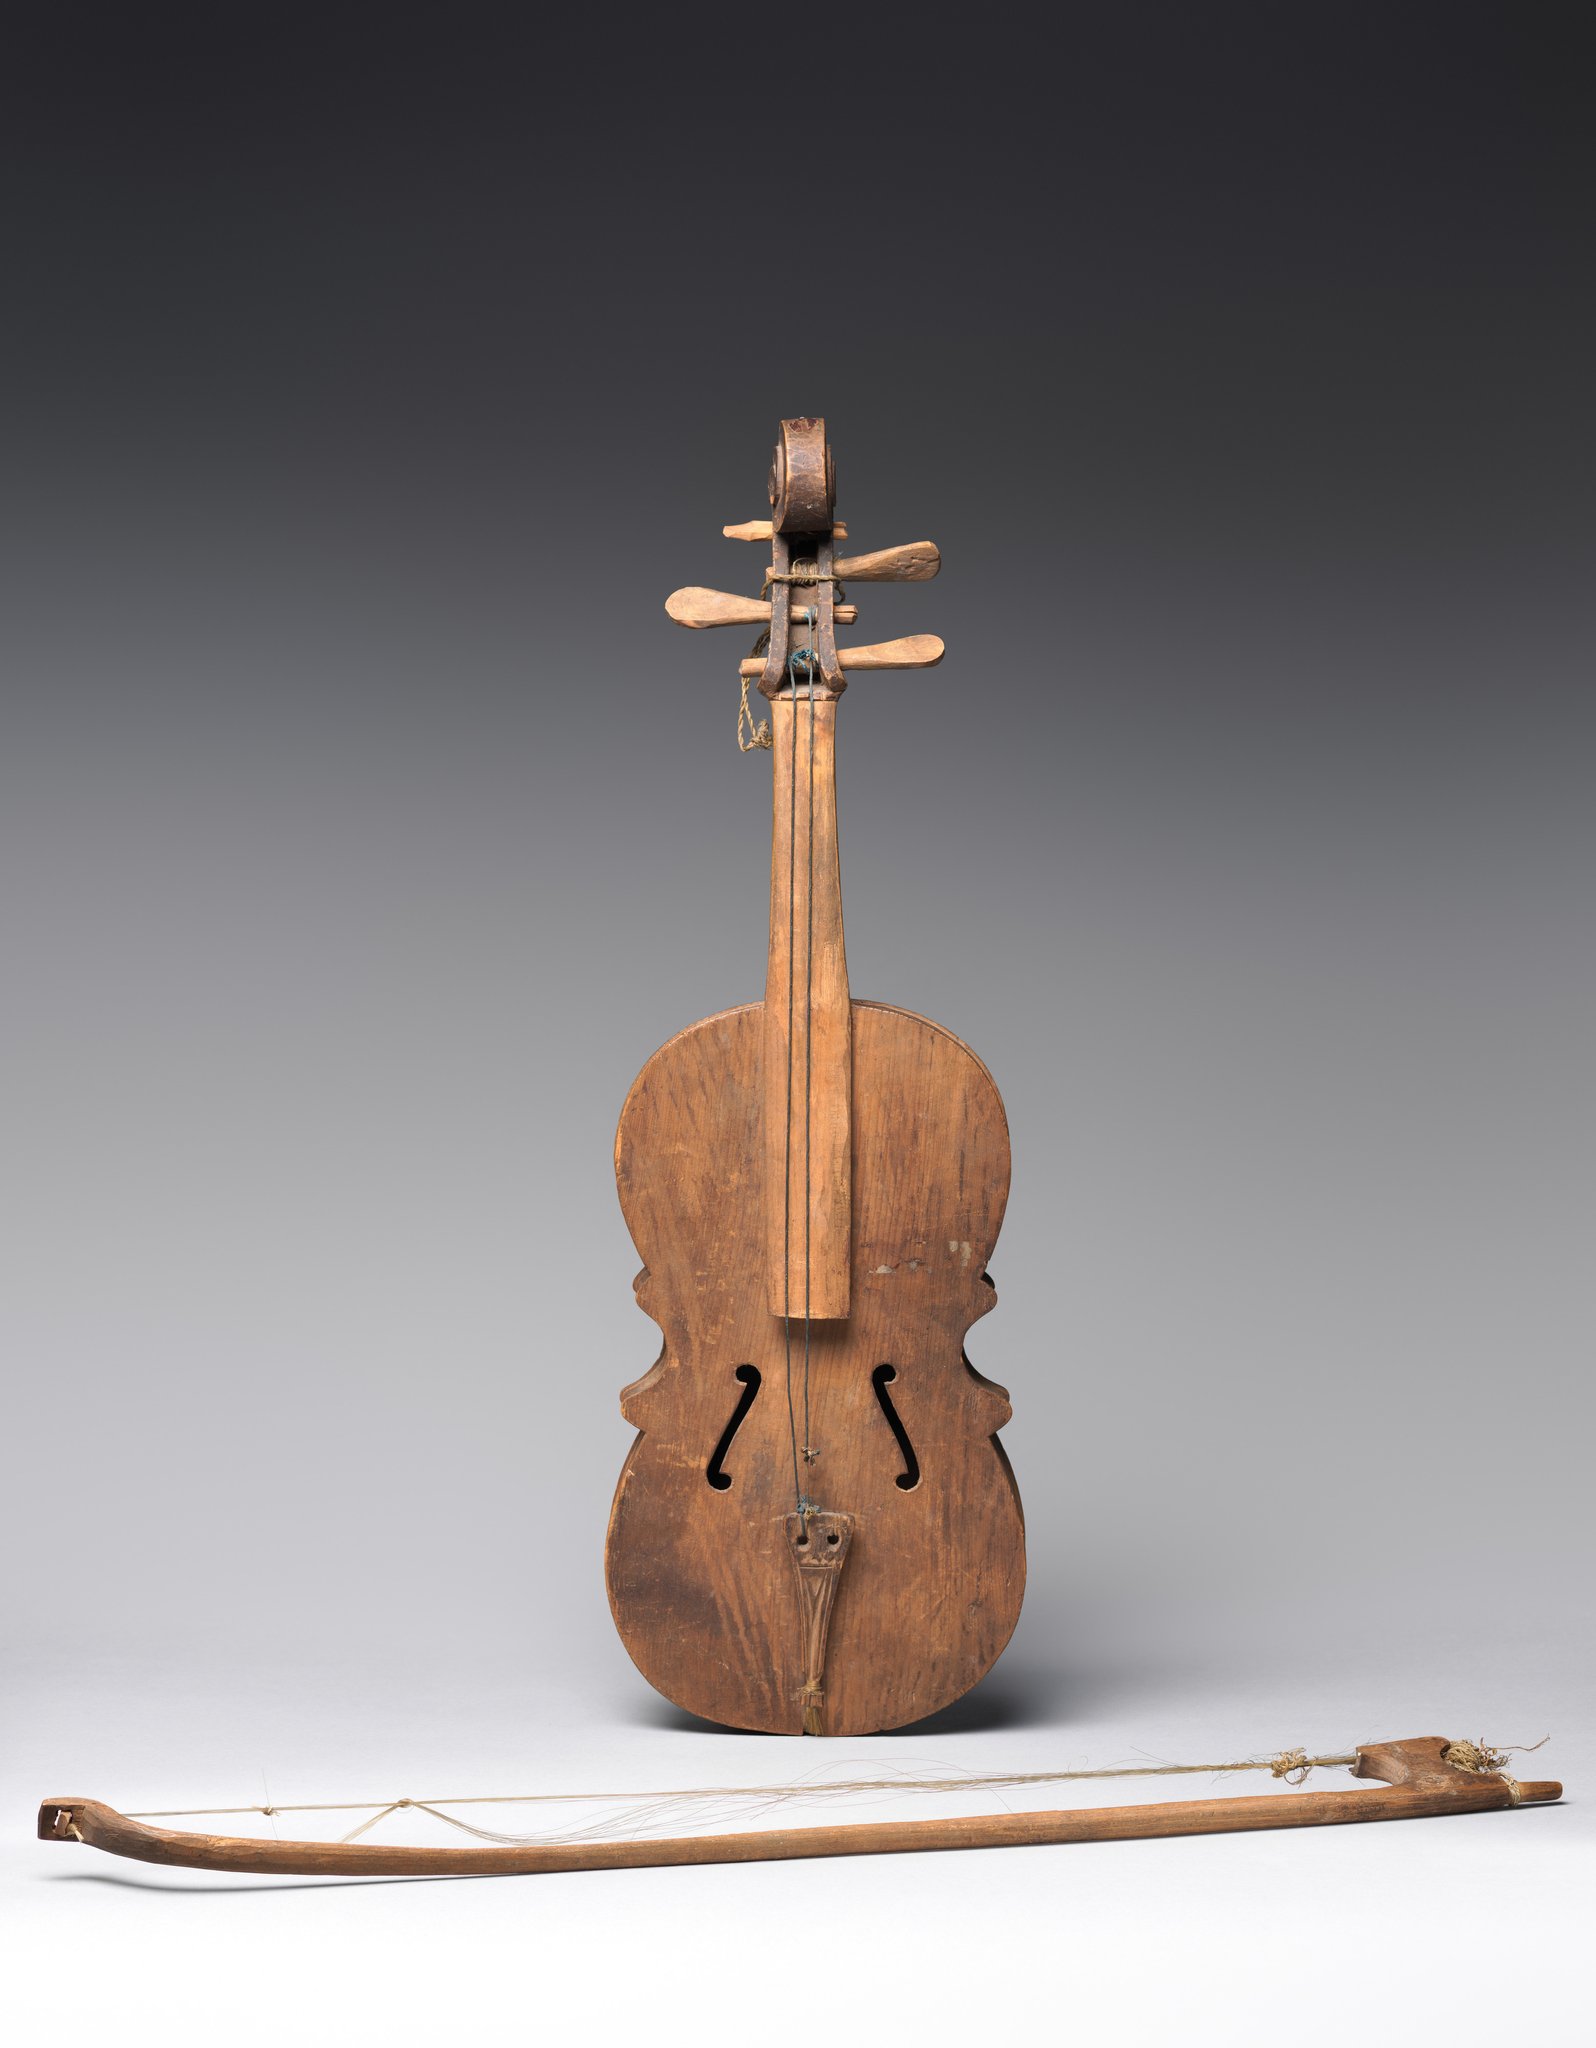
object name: violin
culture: russian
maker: chukchee people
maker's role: culture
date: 1800-1889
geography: russia